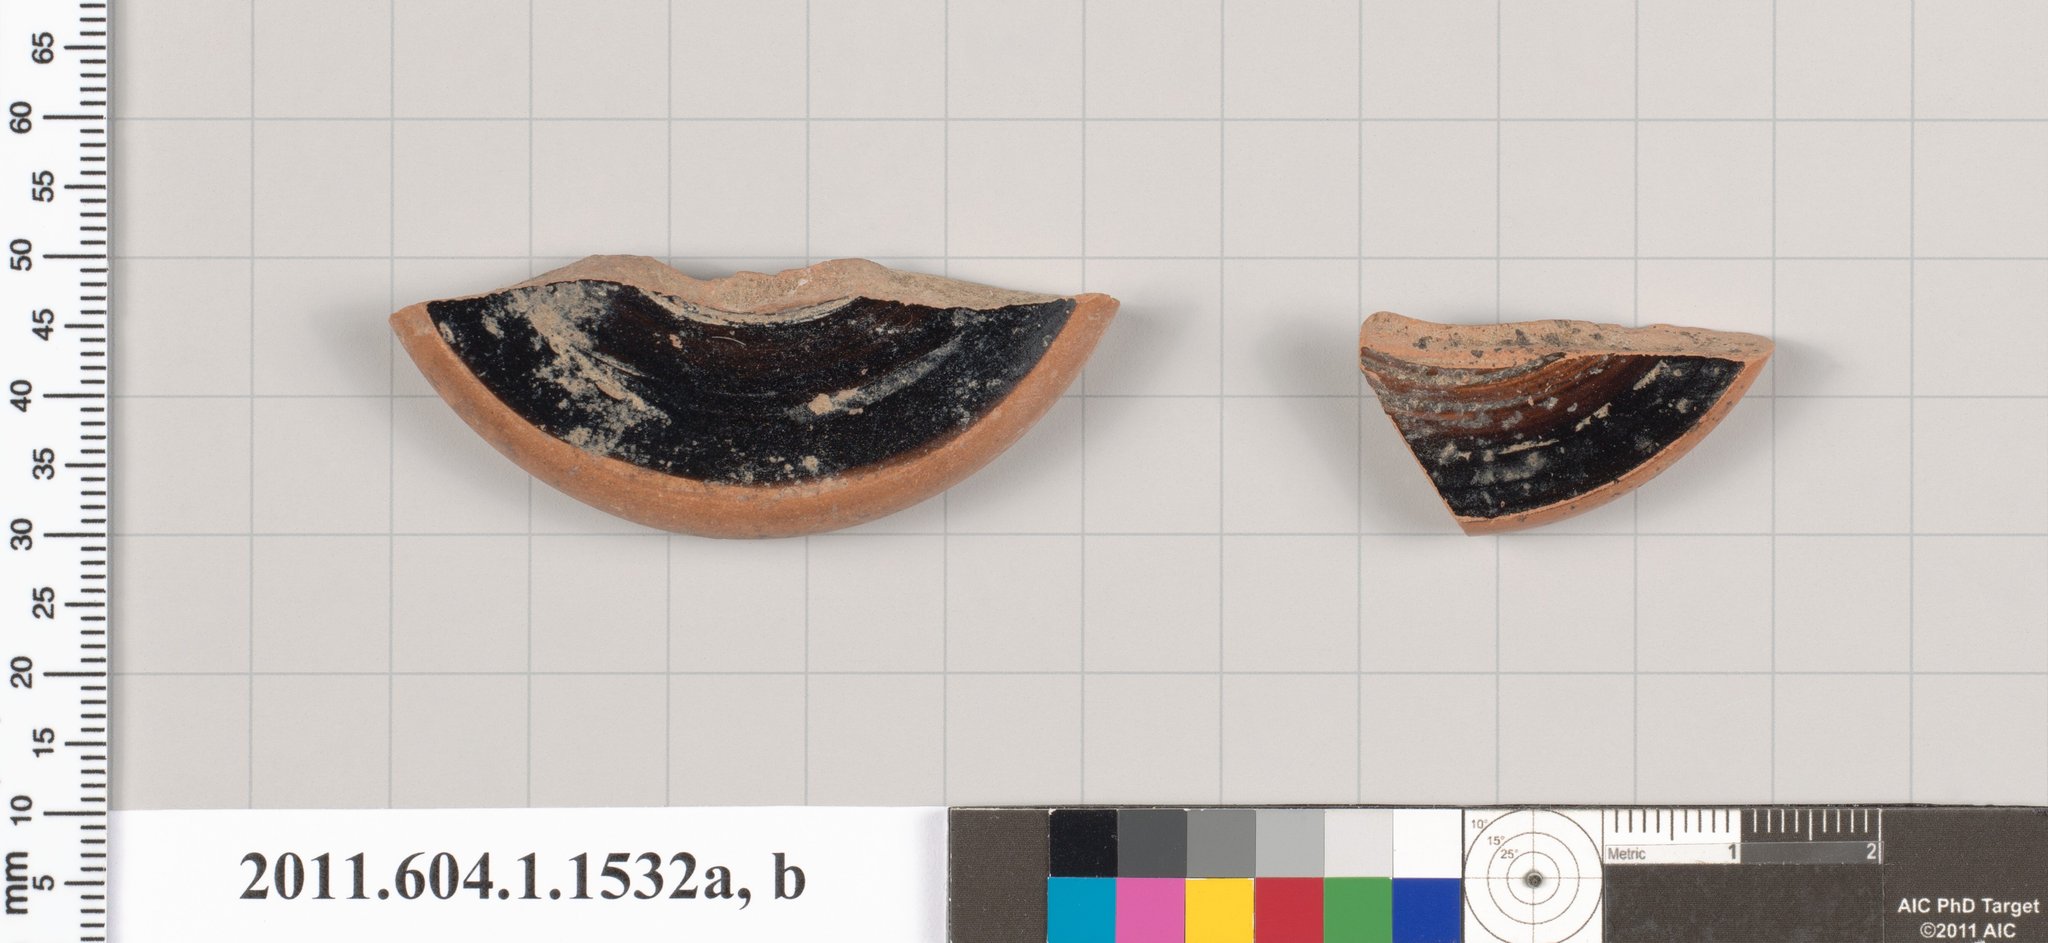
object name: kylix fragment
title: Terracotta fragments of kylikes (drinking cups)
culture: greek, attic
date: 500-401 BCE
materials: terracotta